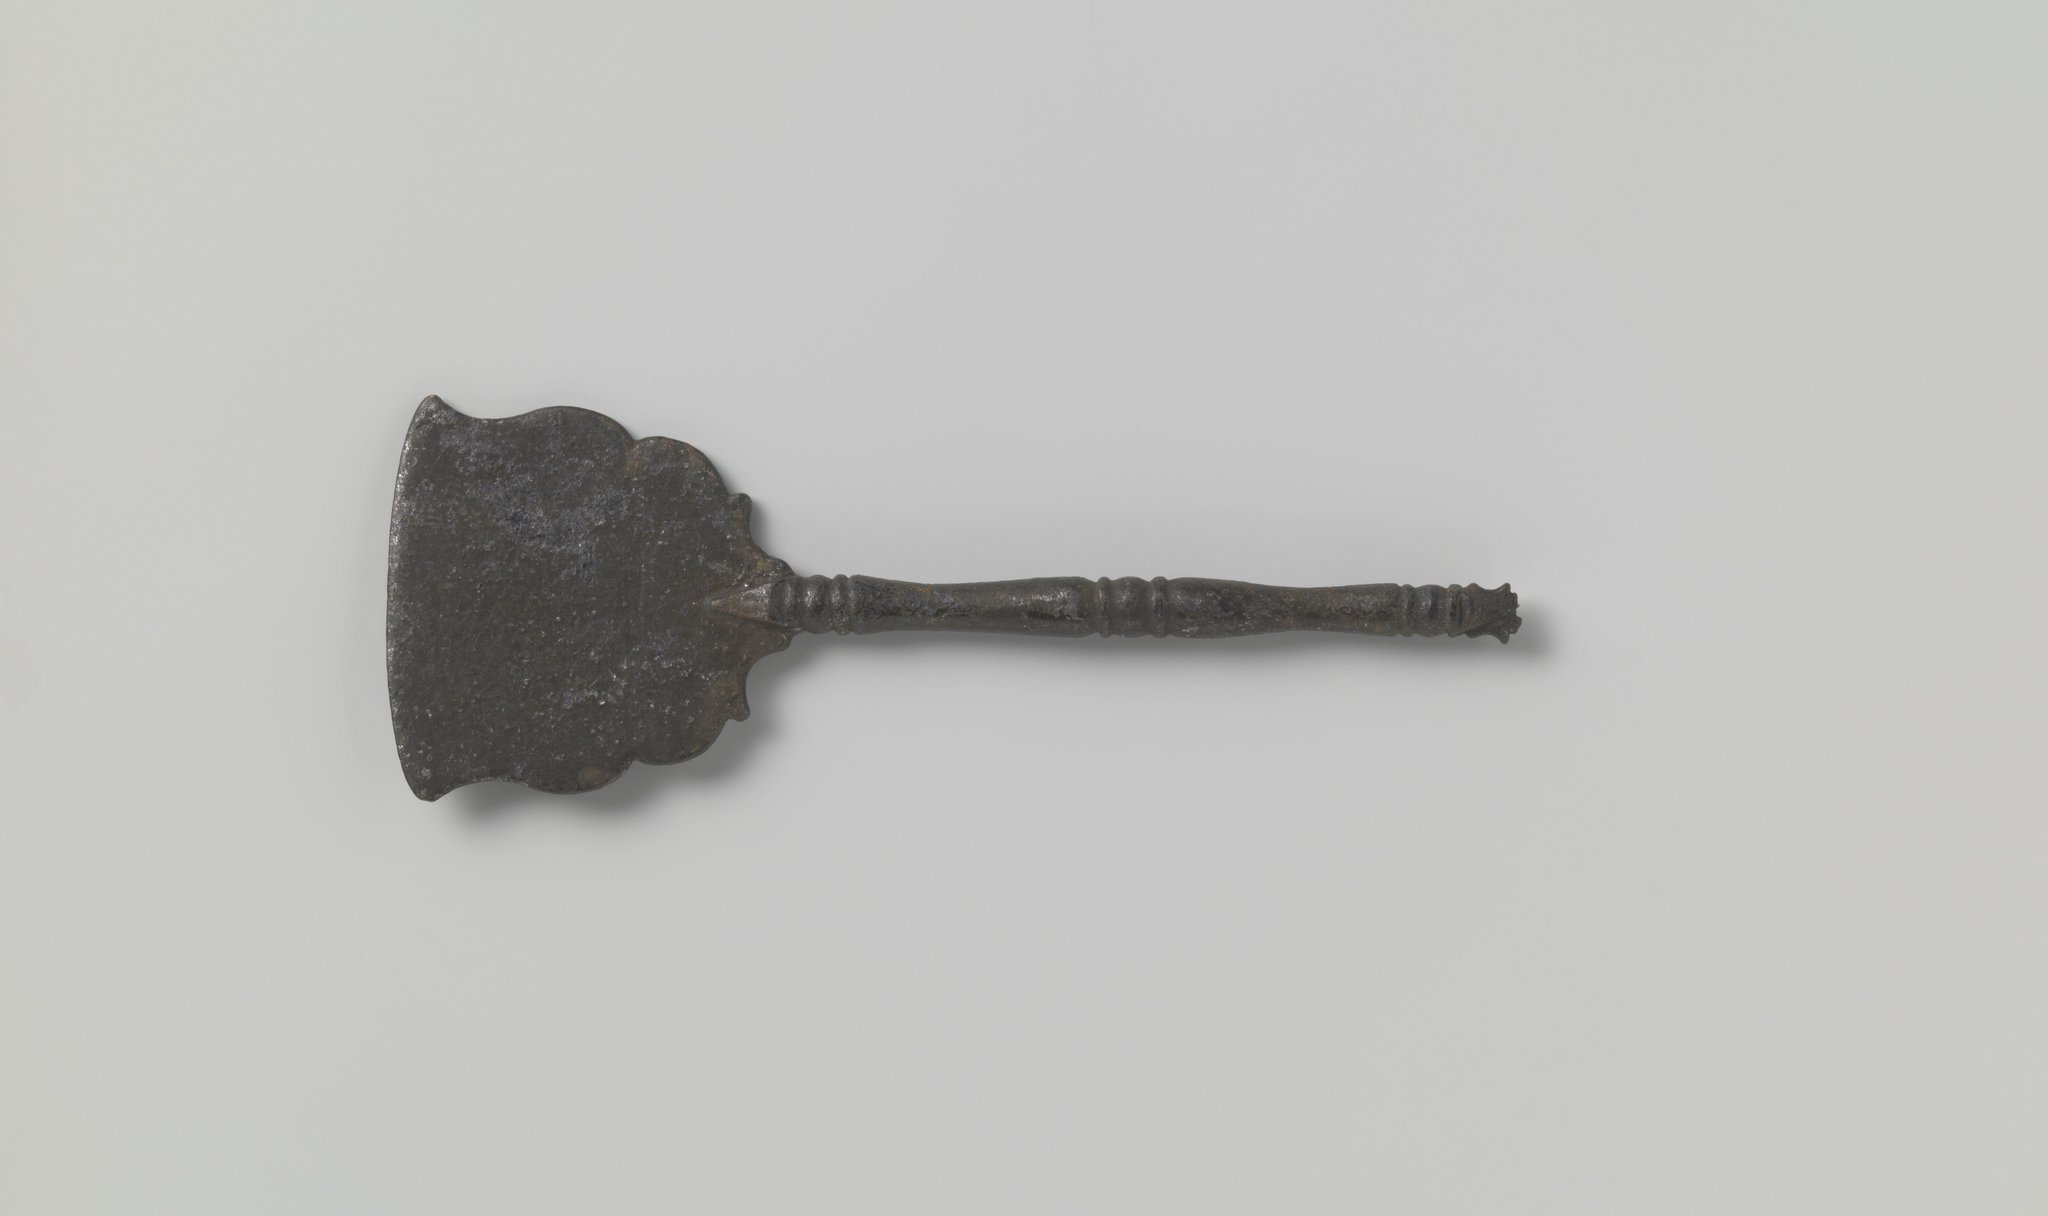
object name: schop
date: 1400-1950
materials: iron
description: Een ijzeren schop behorend bij talklamp.